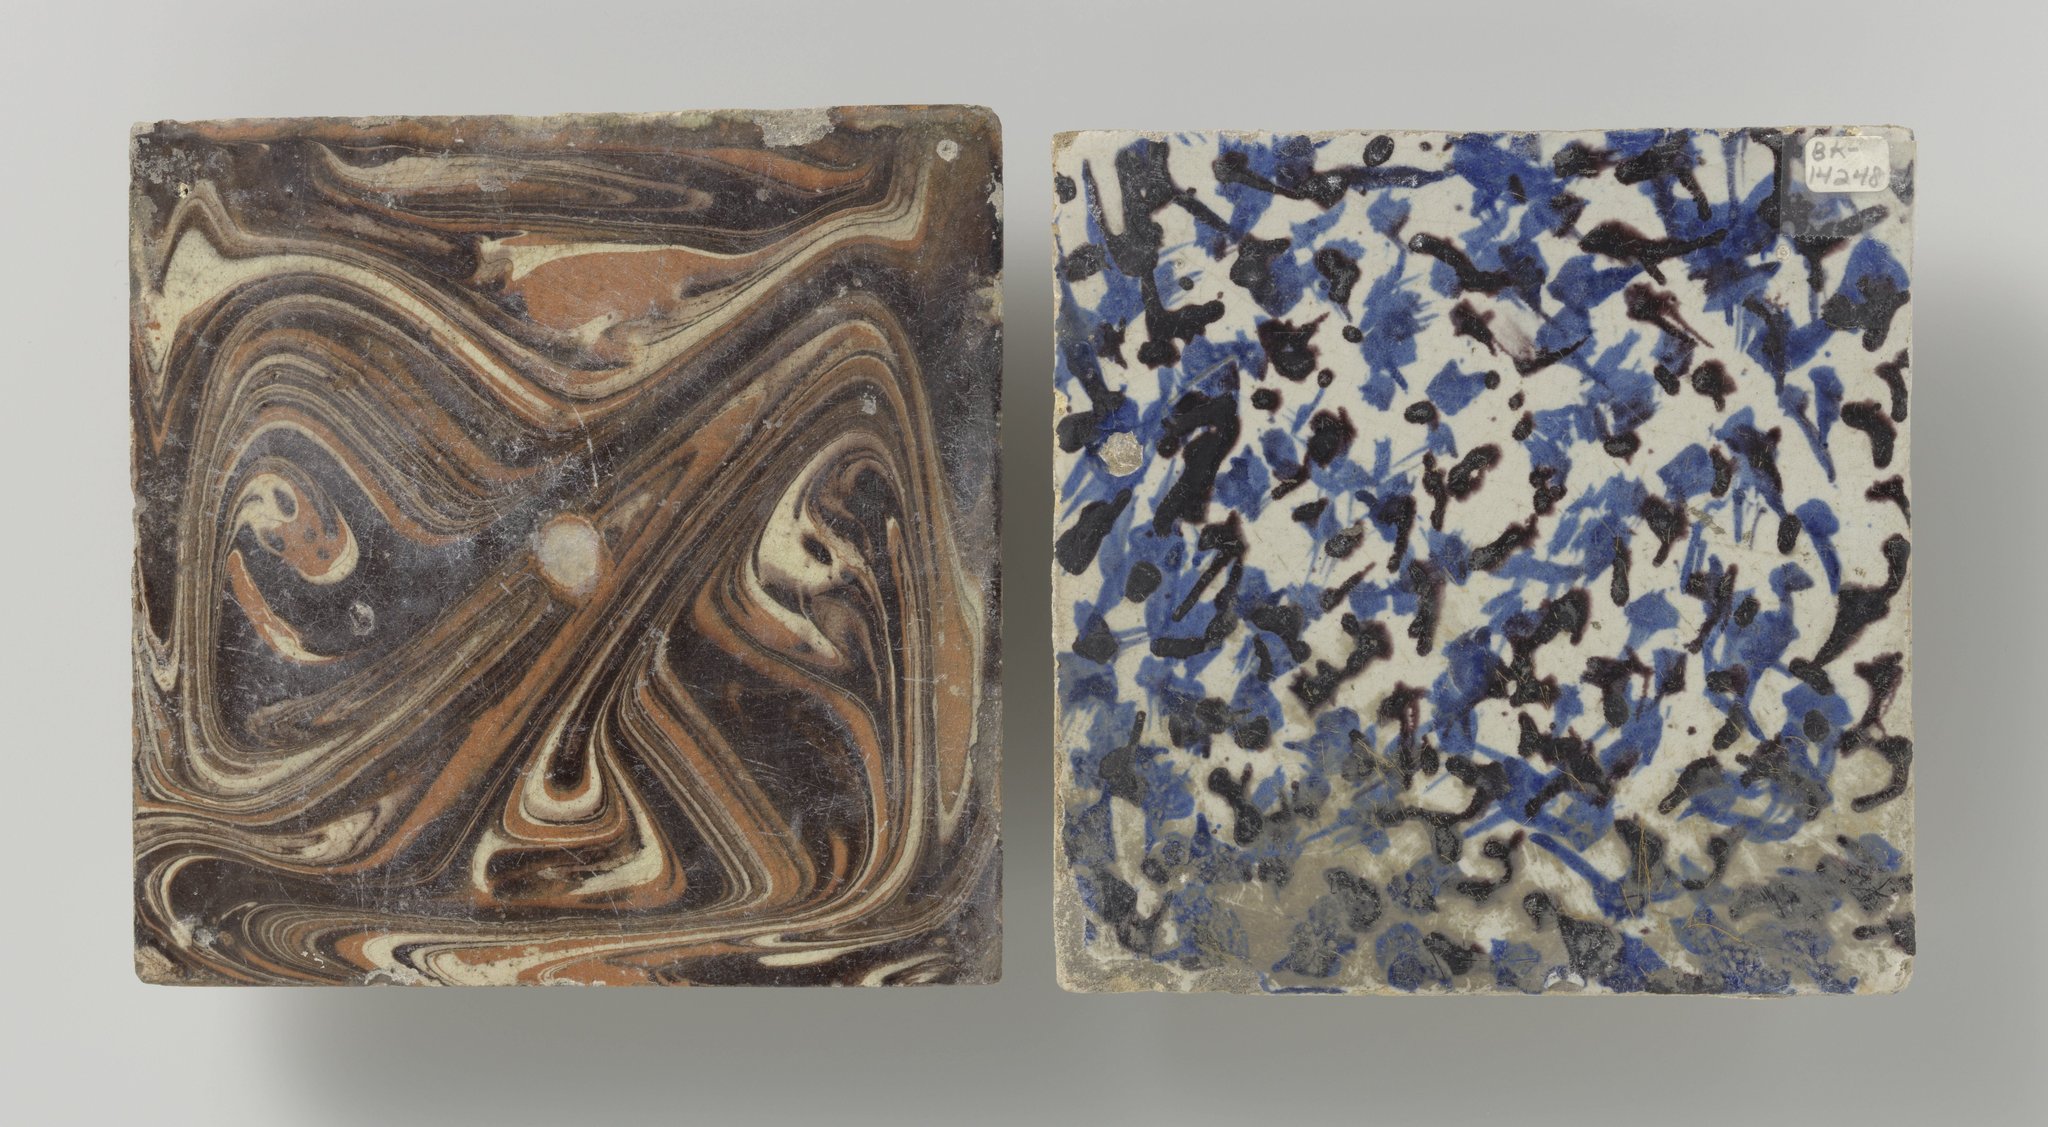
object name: tile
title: Twee gemarmerde tegels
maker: Anonymous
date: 1650-1700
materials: earthenware, glaze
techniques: maiolica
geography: netherlands